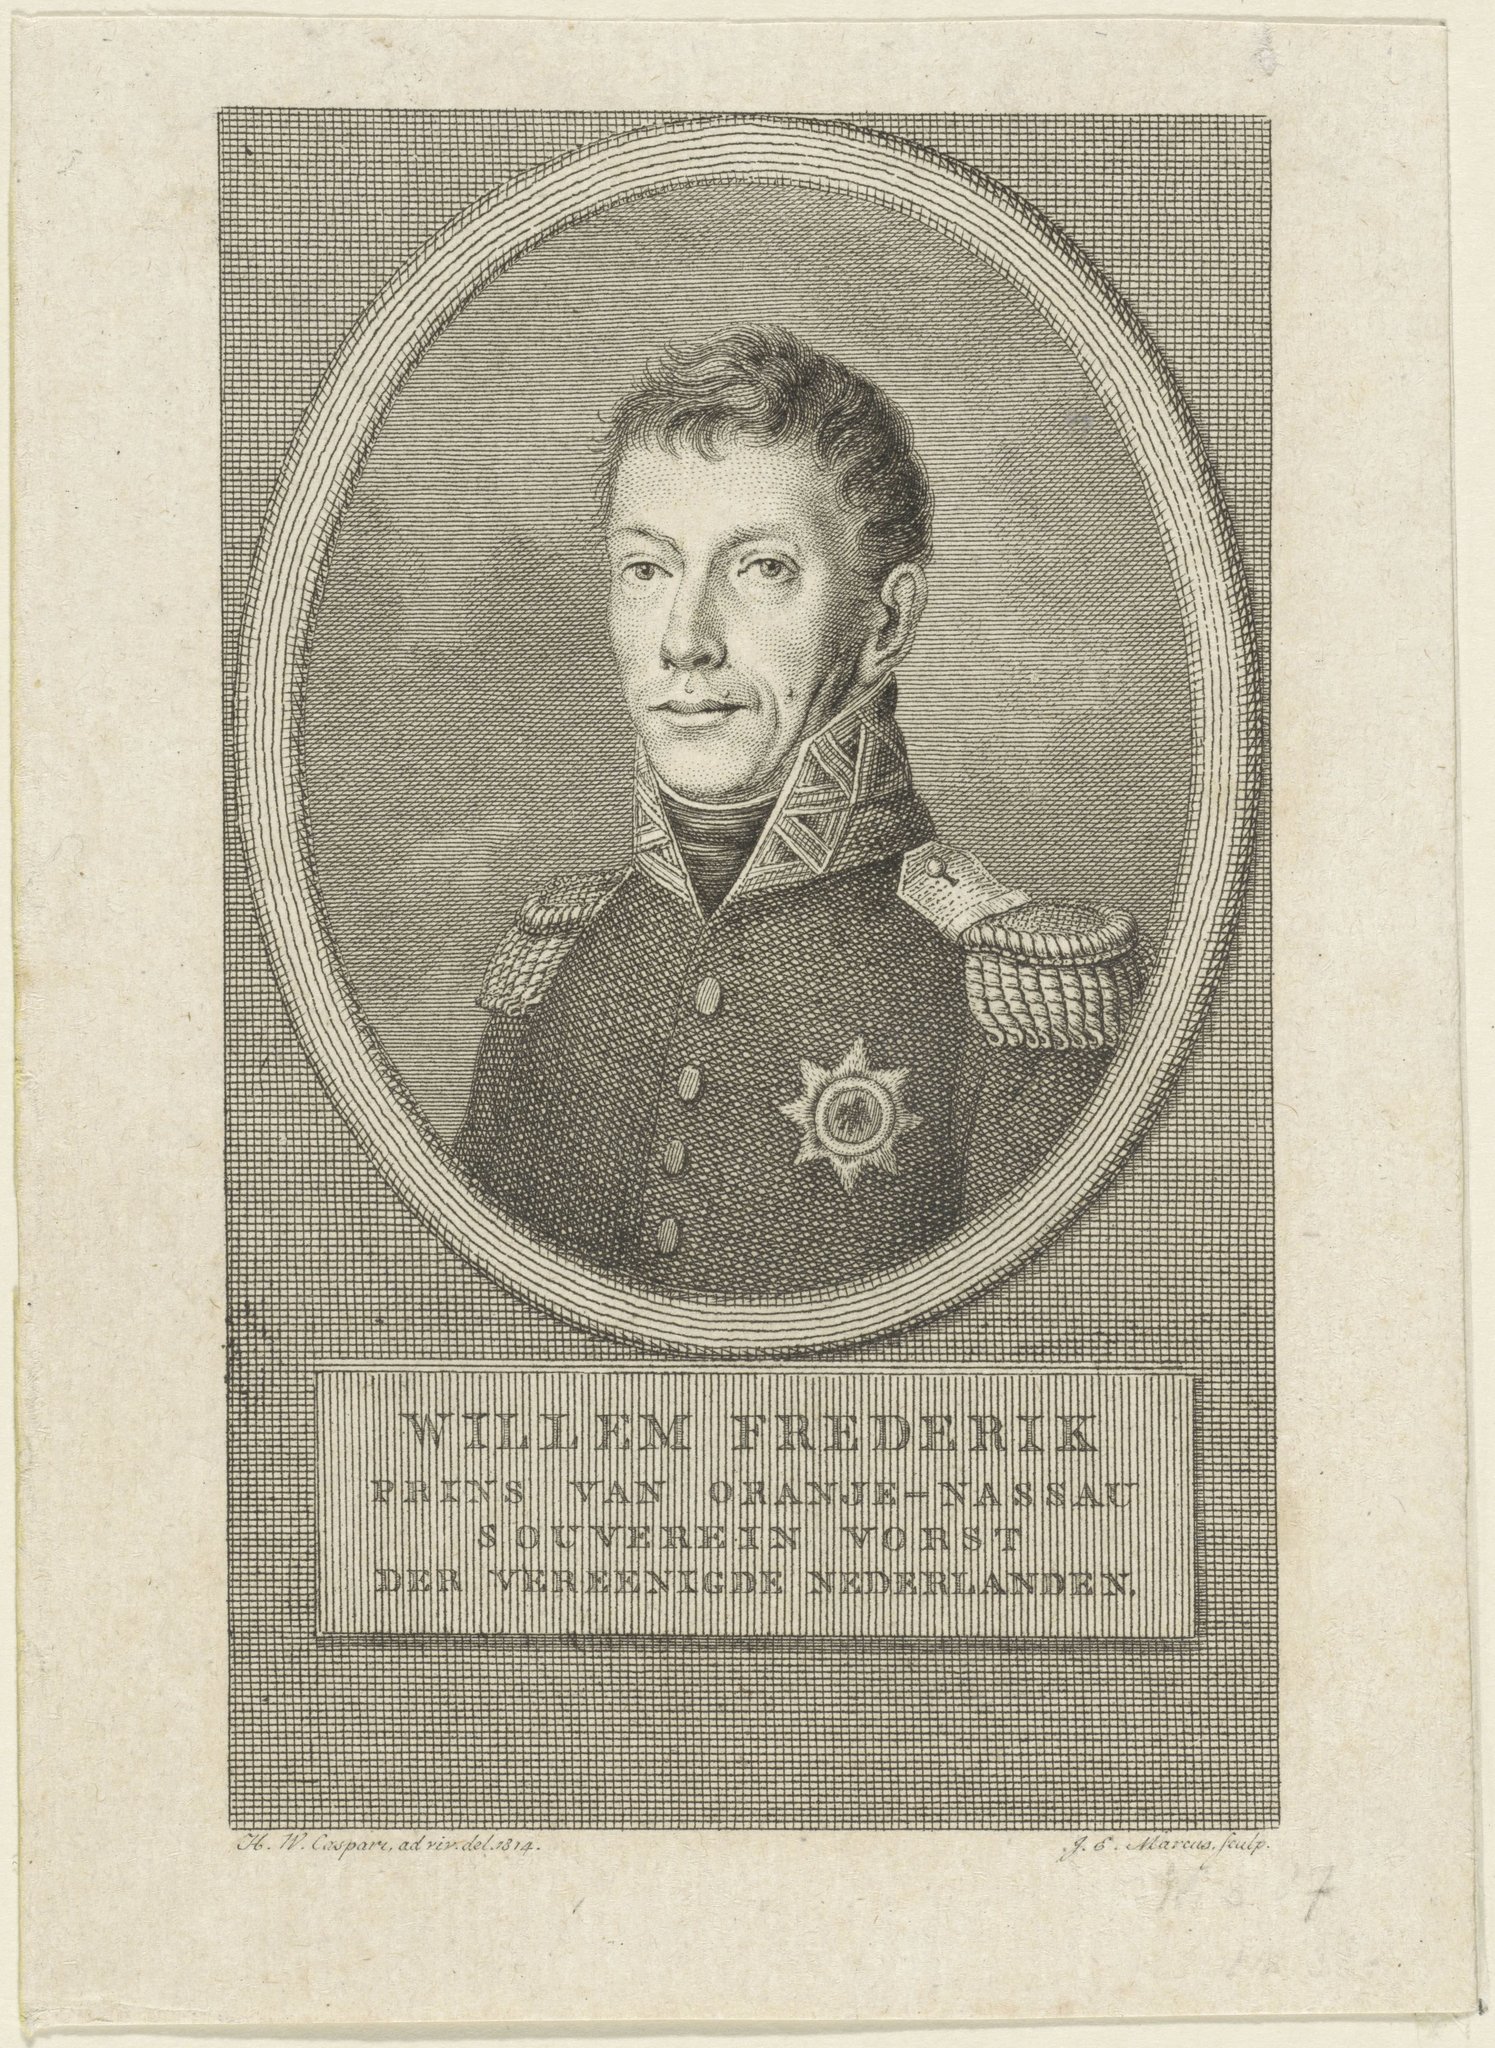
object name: print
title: Portret van Willem I Frederik, koning der Nederlanden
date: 1814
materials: paper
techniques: engraving, etching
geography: amsterdam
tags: the hague, berlin, william i of the netherlands, knighthood order (with name) - insignia of a knighthood order, e.g.: badge, chain (with name of order)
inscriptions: date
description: De hier vermelde titel verwijst naar de hoogst verkregen titel van de geportretteerde, niet per se naar de titel die de geportretteerde op deze voorstelling draagt.